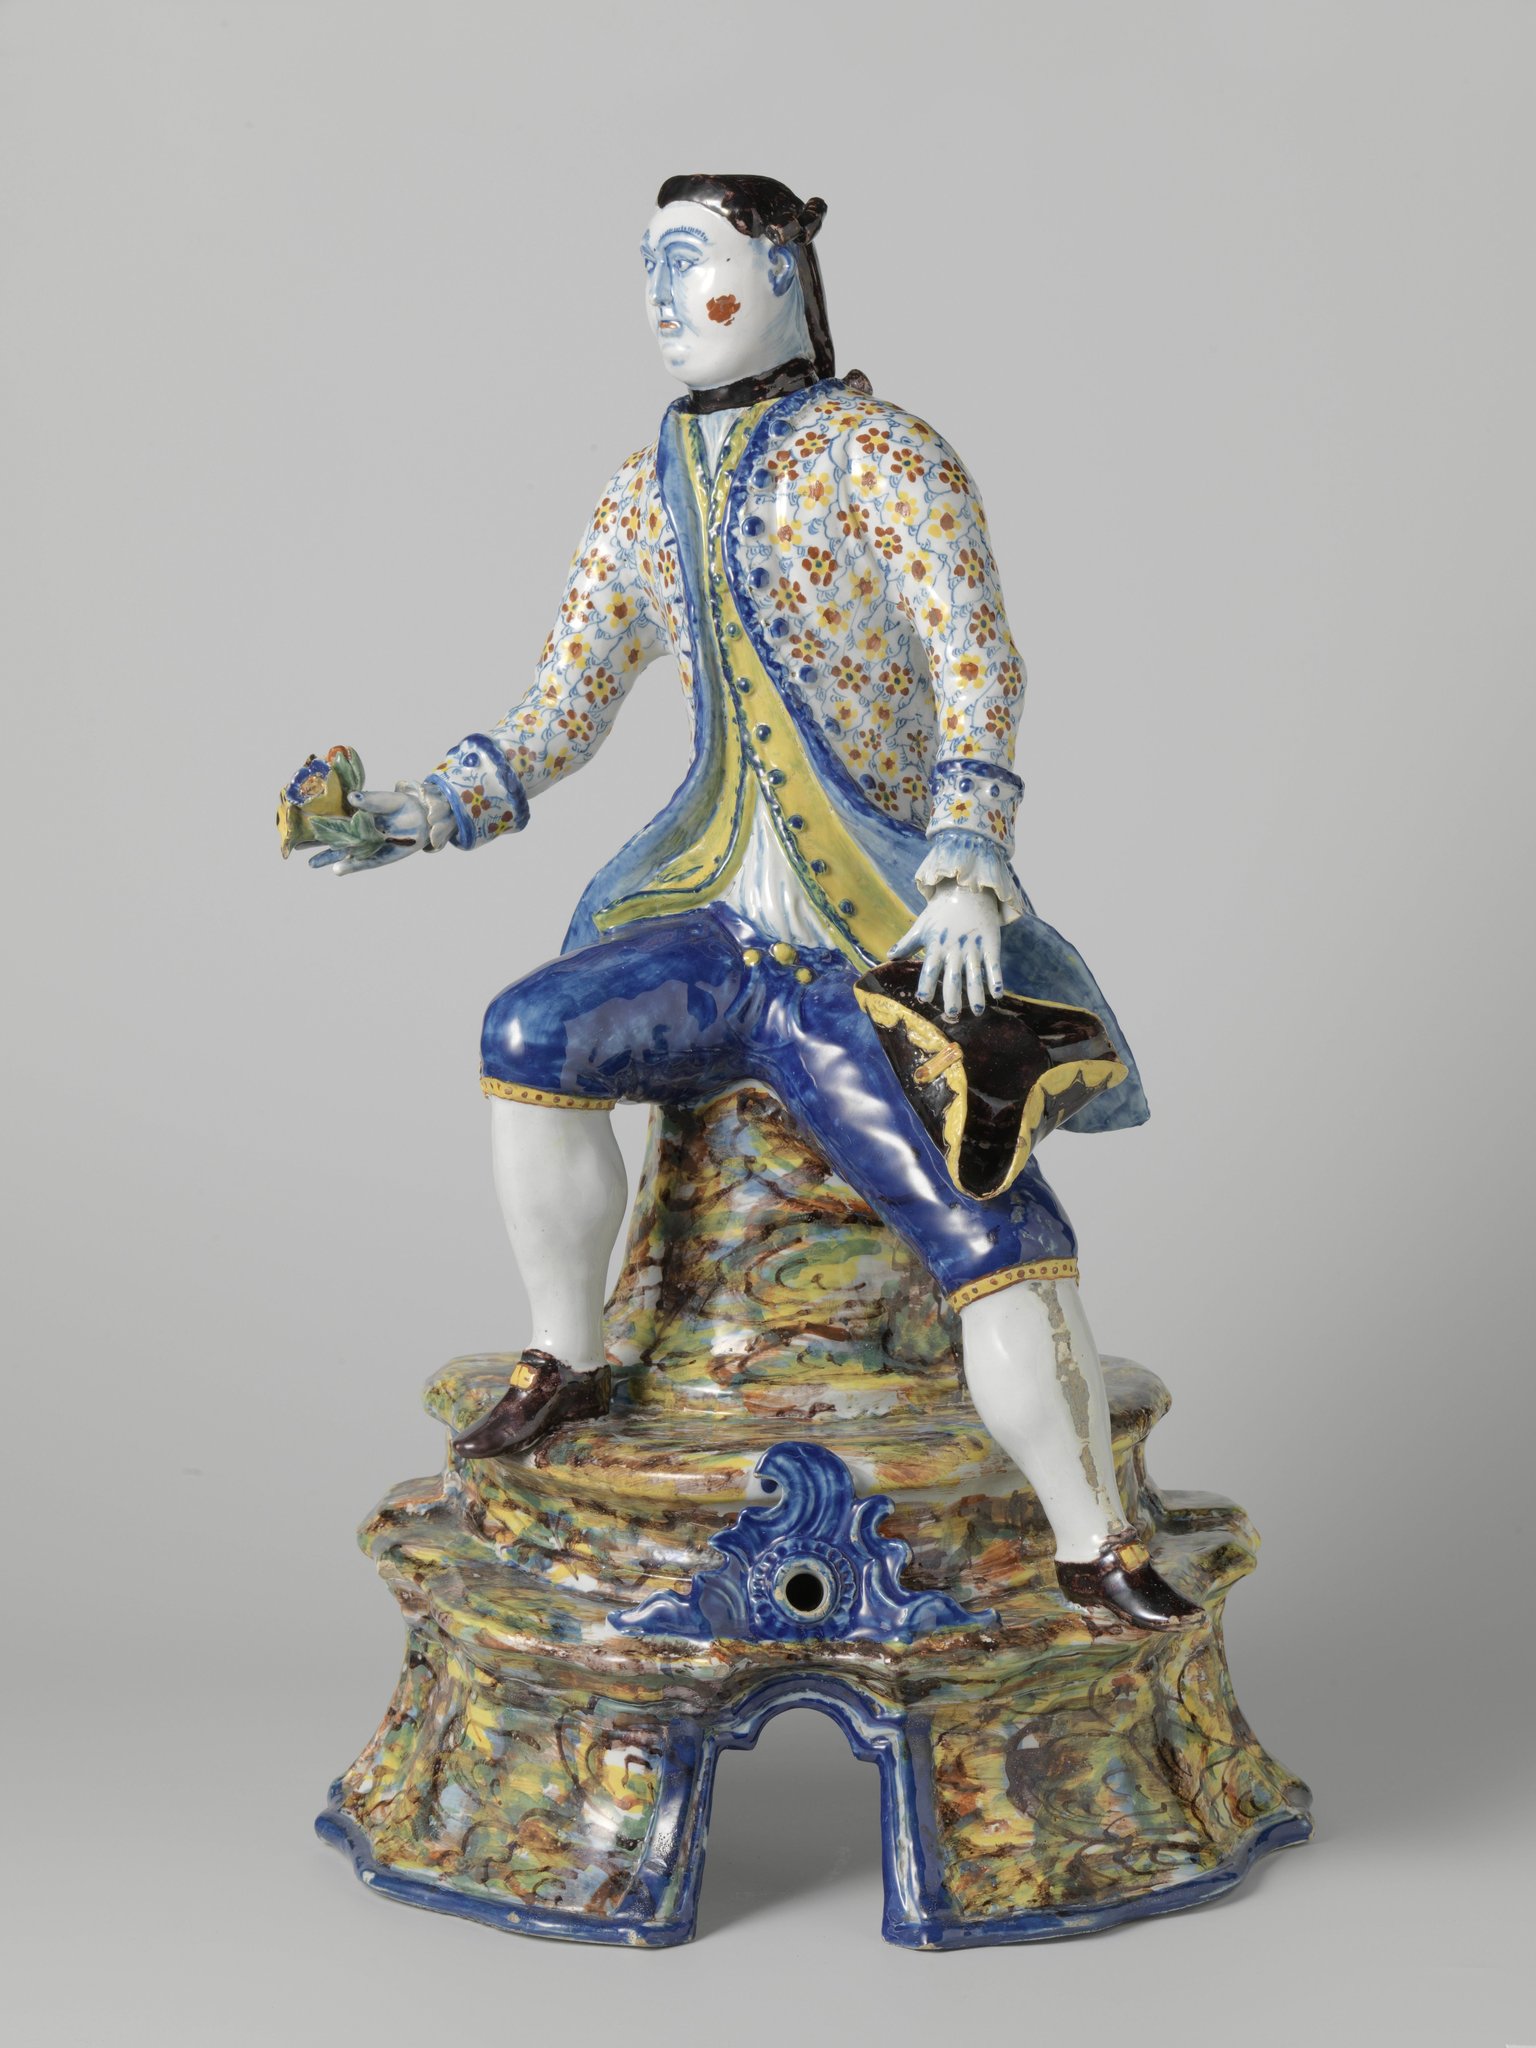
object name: decoratief object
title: Hand van fontein in de vorm van een zittende man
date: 1760-1775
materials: earthenware, glaze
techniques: painted, polychromy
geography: delft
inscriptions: mark: ‘figuratief teken klauw’, collector's mark: ‘collection JF Loudon’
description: Hand van fontein van veelkleurig beschilderde faïence.